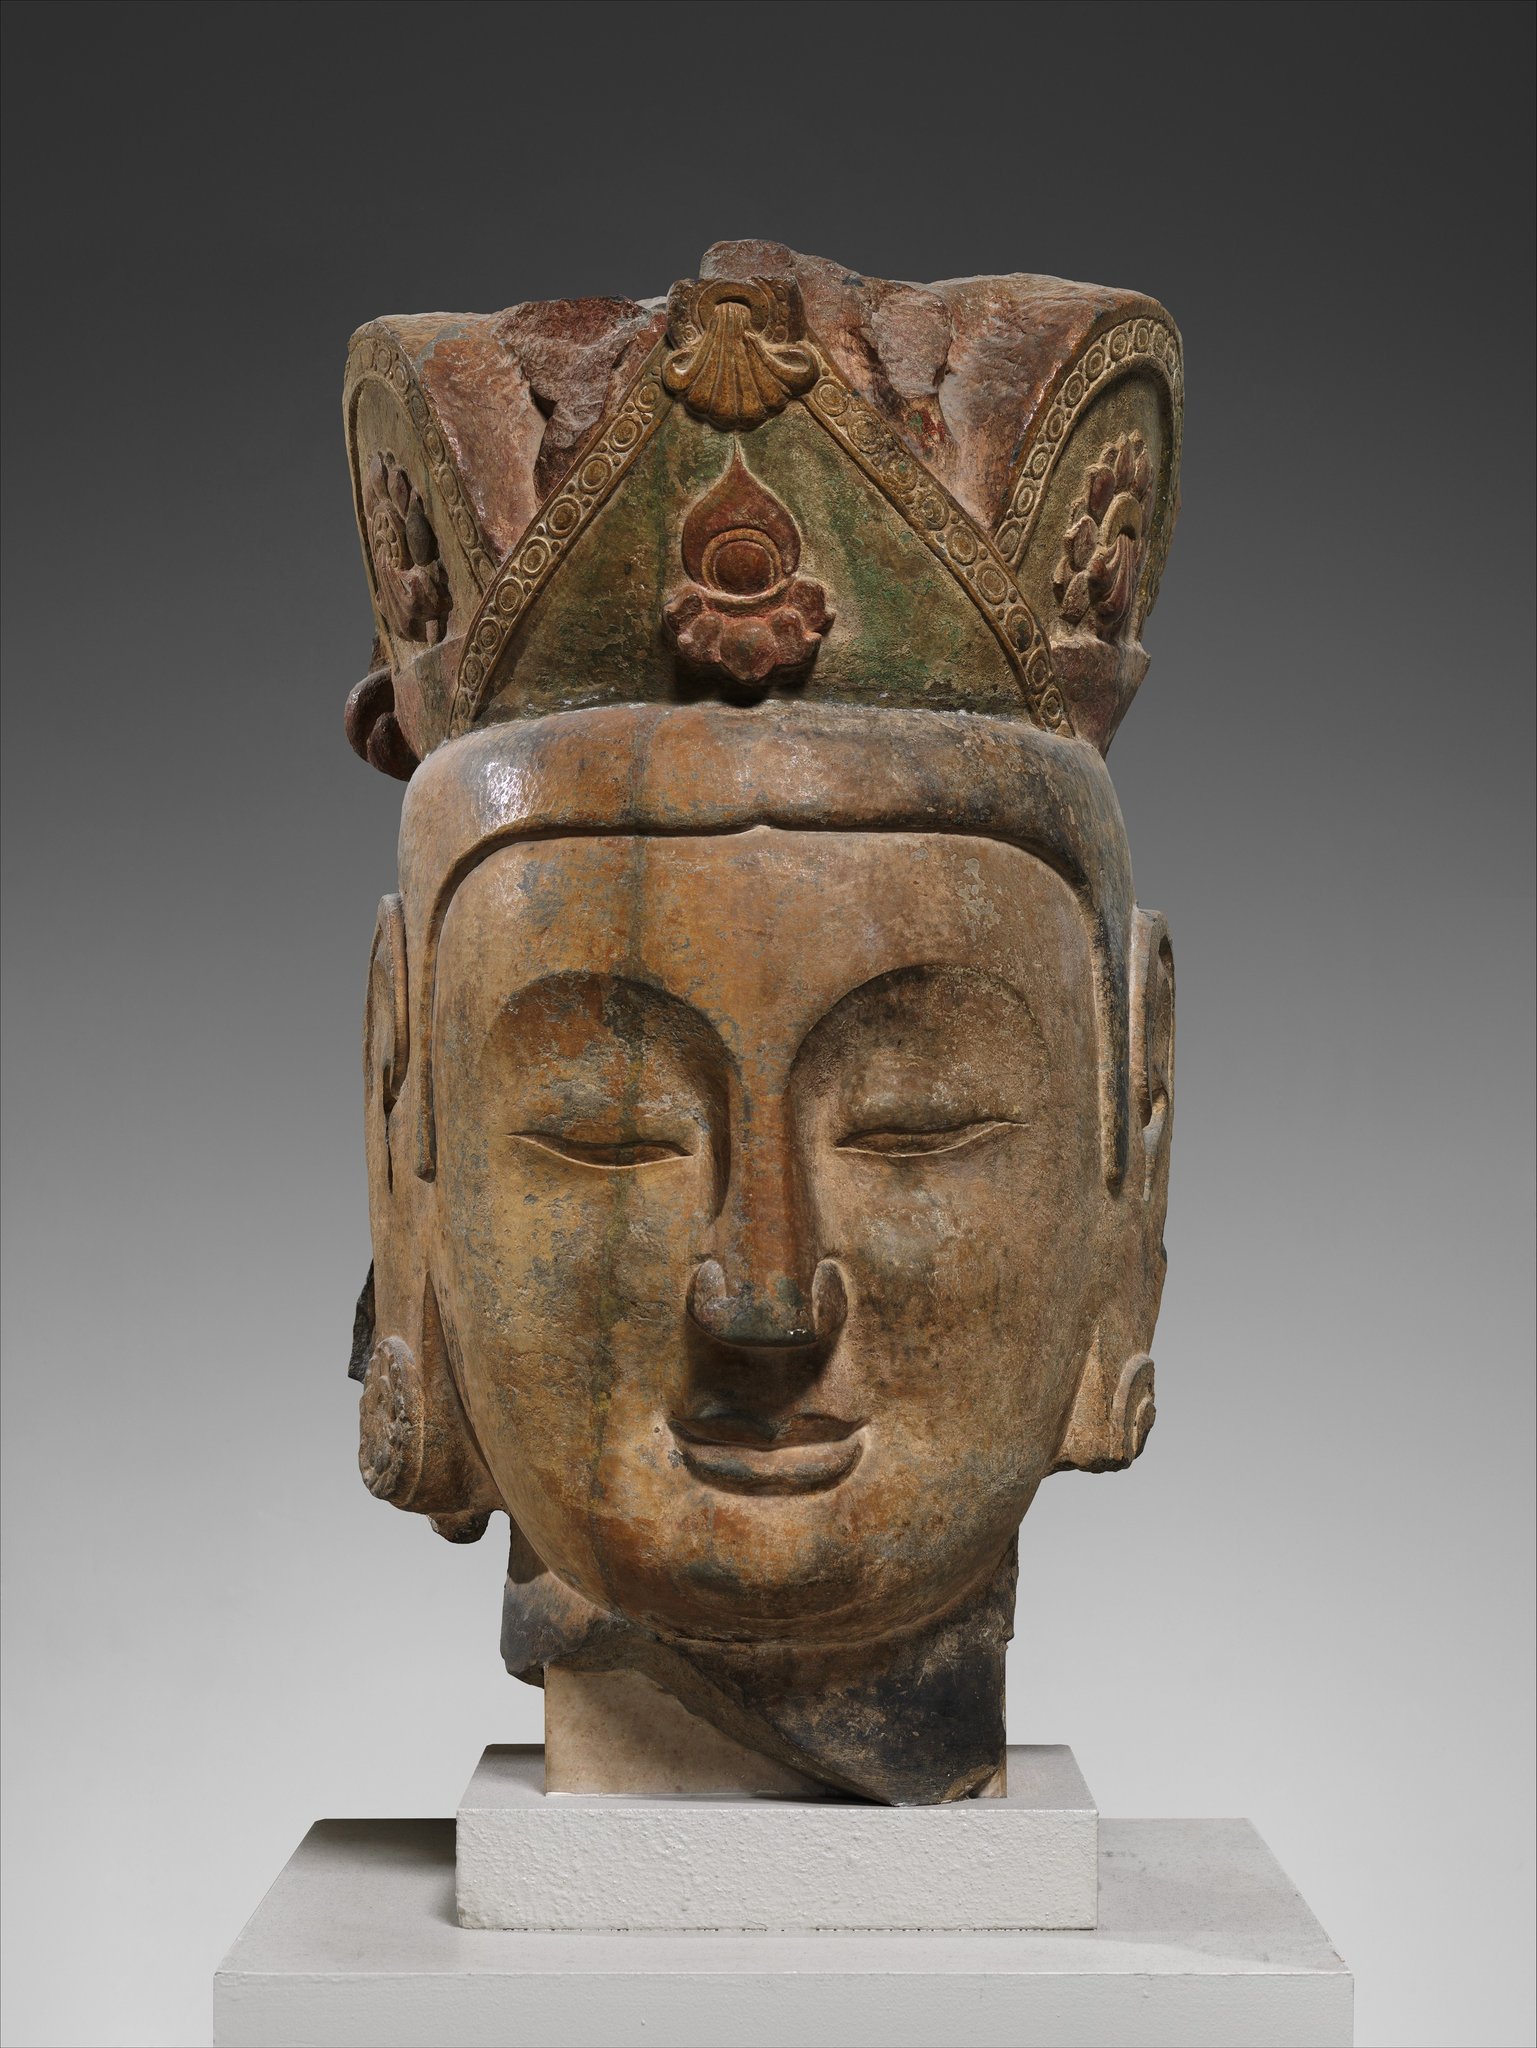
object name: head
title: Head of a bodhisattva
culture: chinese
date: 565-575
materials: limestone, pigment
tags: heads,buddhism,bodhisattvas